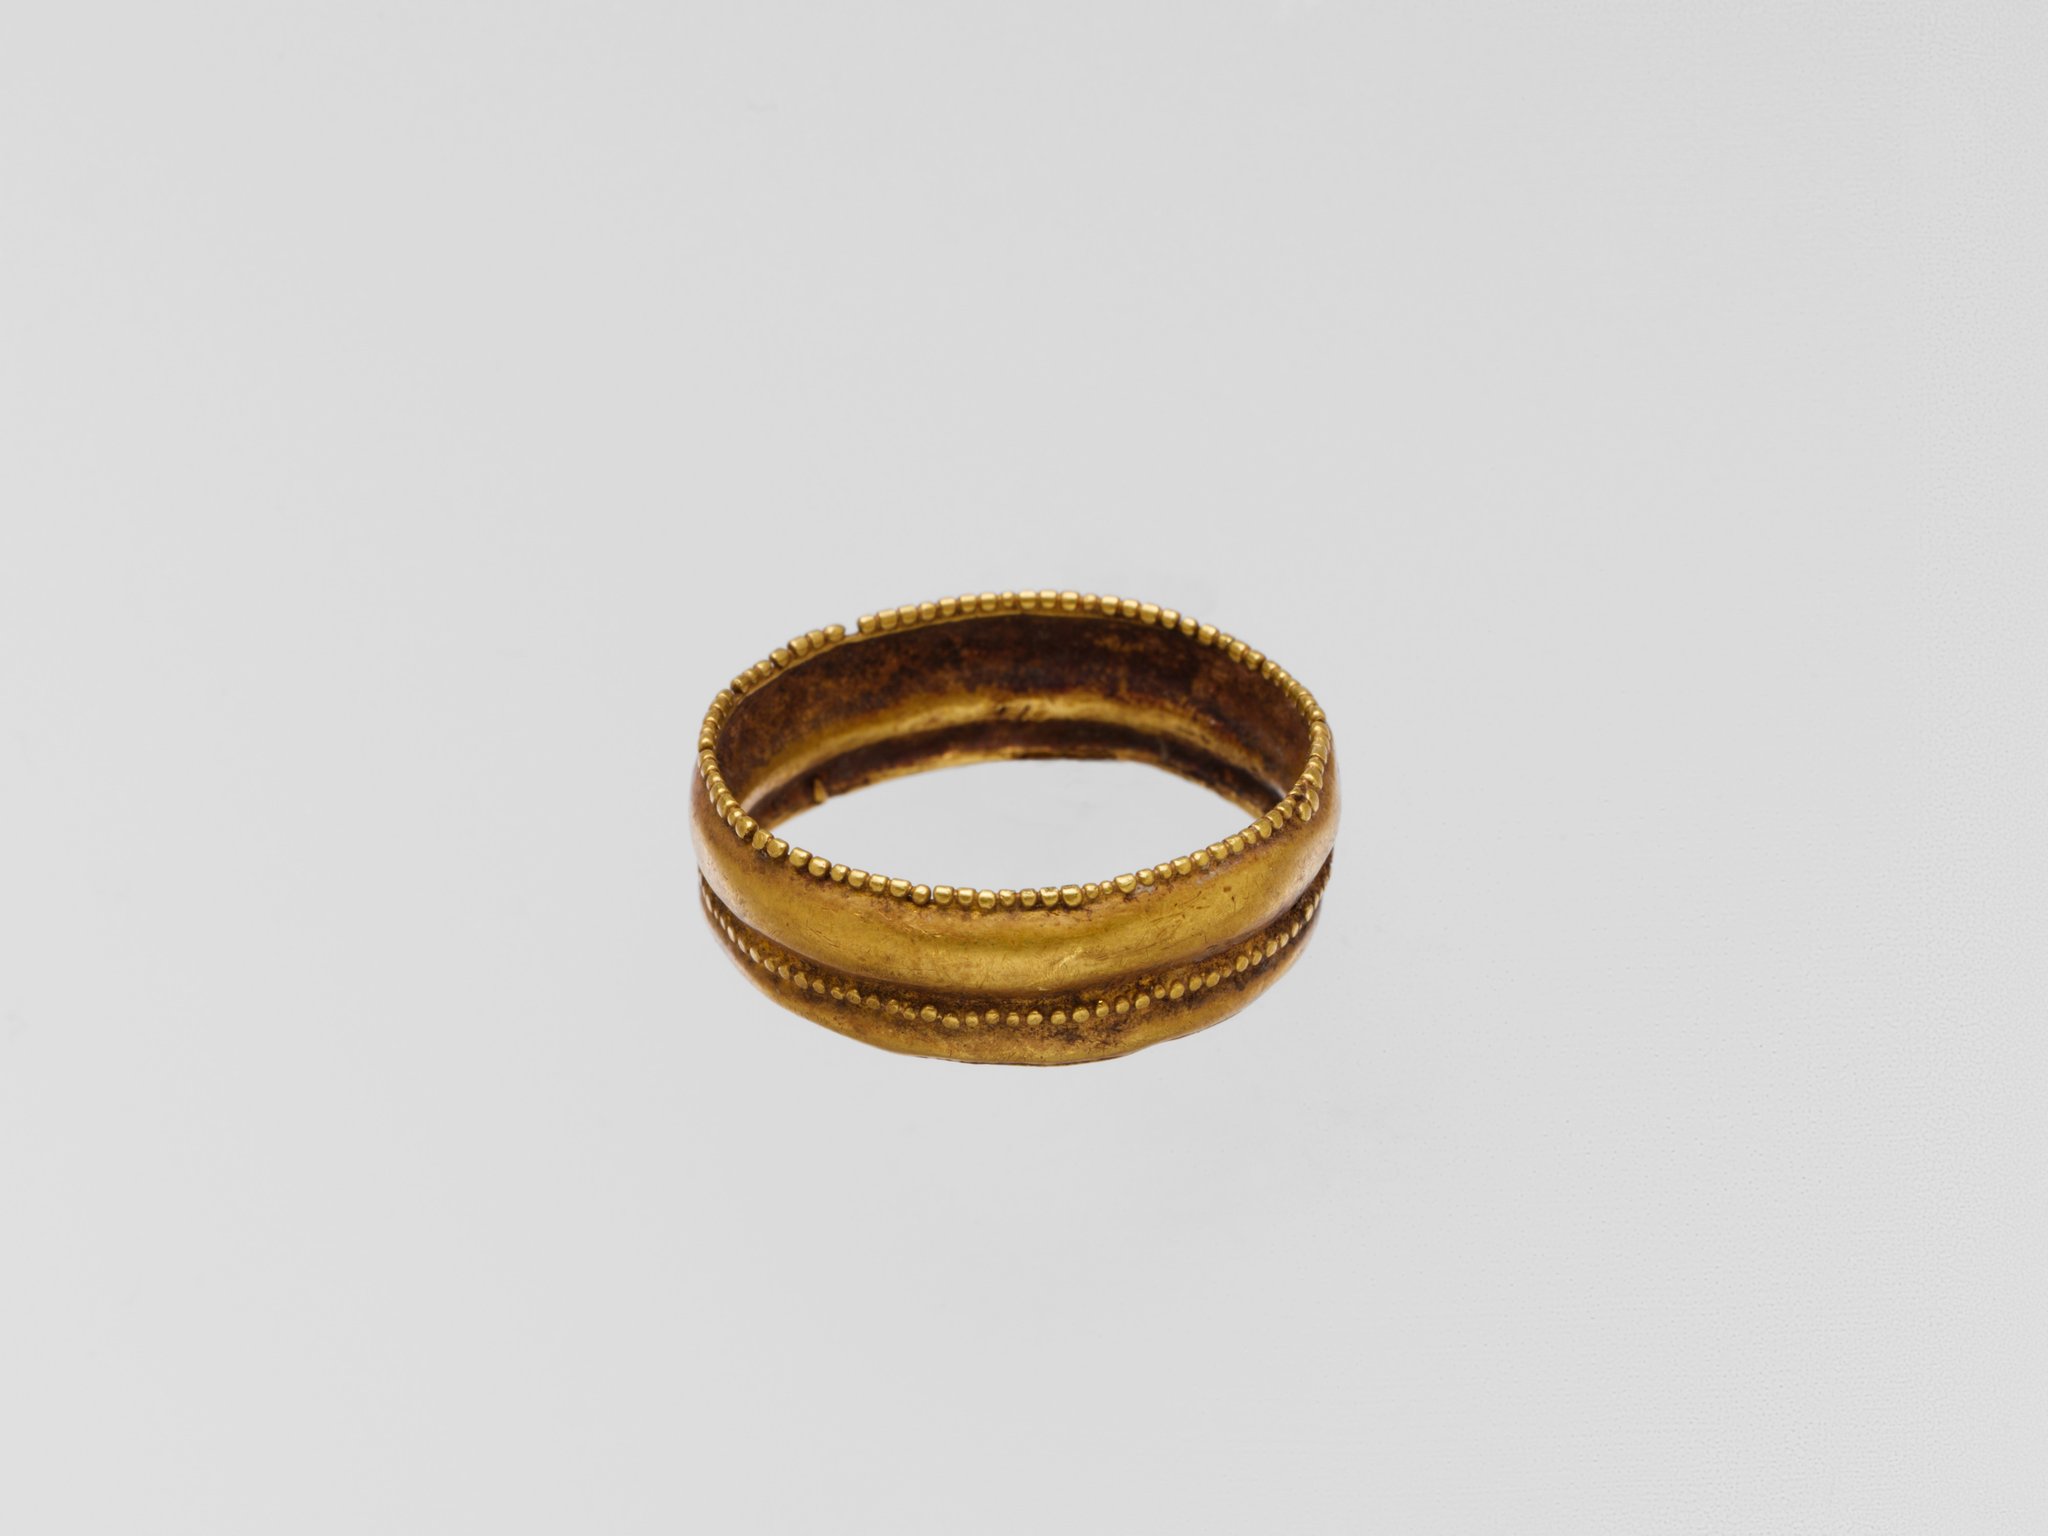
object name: ring with moulding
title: Gold ring with two horizontal ribs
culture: cypriot or greek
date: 800-601 BCE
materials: gold